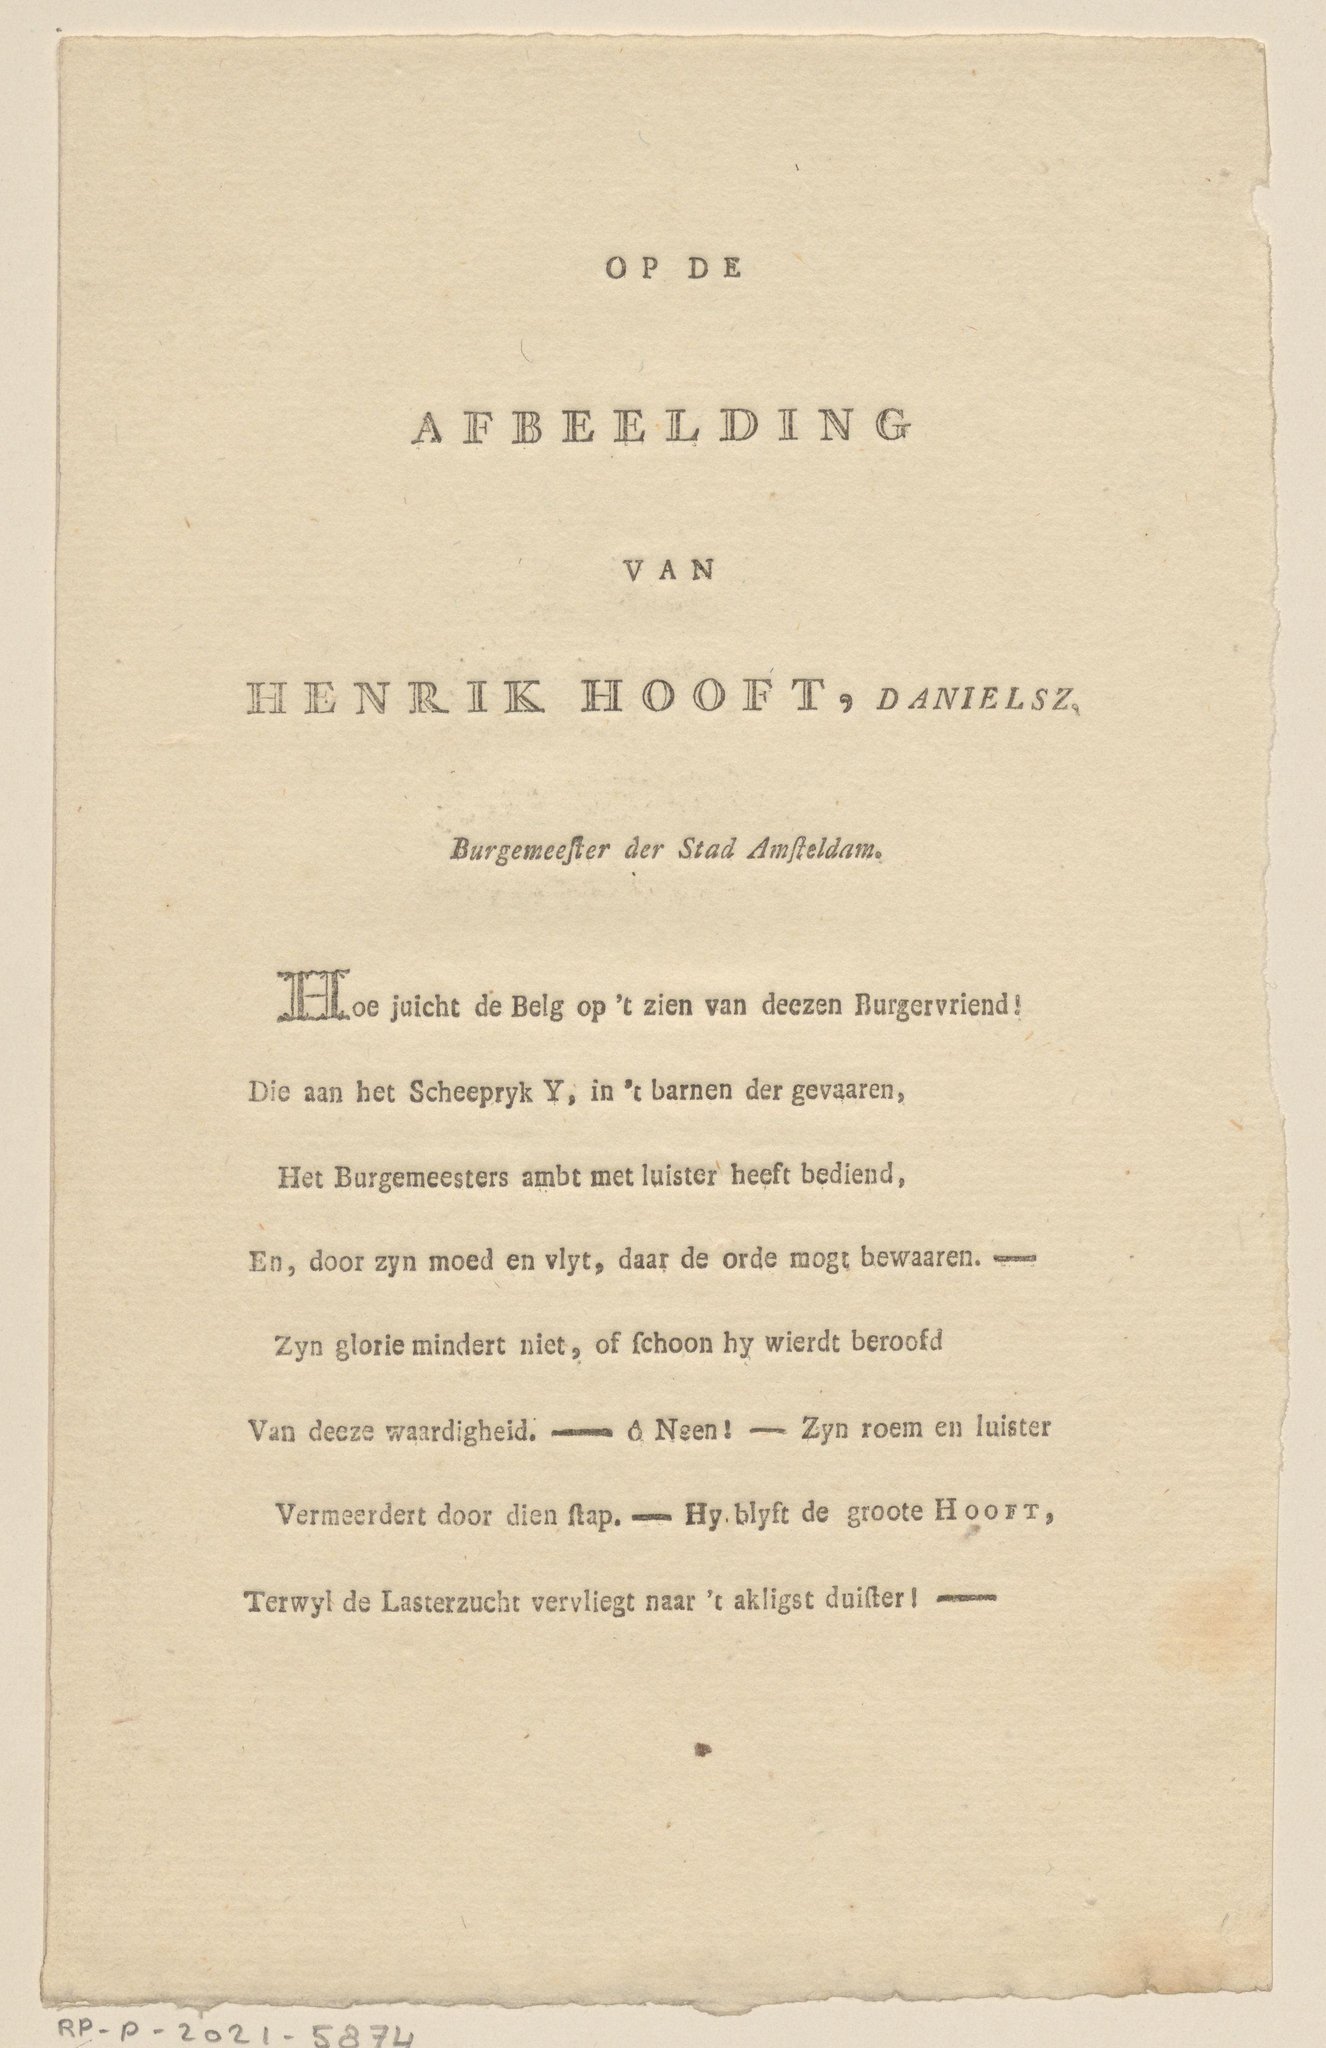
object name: text sheet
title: Bijschrift bij een portret van Hendrik Danielsz. Hooft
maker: Anonymous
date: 1769-1799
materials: paper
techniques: letterpress printing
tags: amsterdam, mayor, hendrik danielsz. hooft